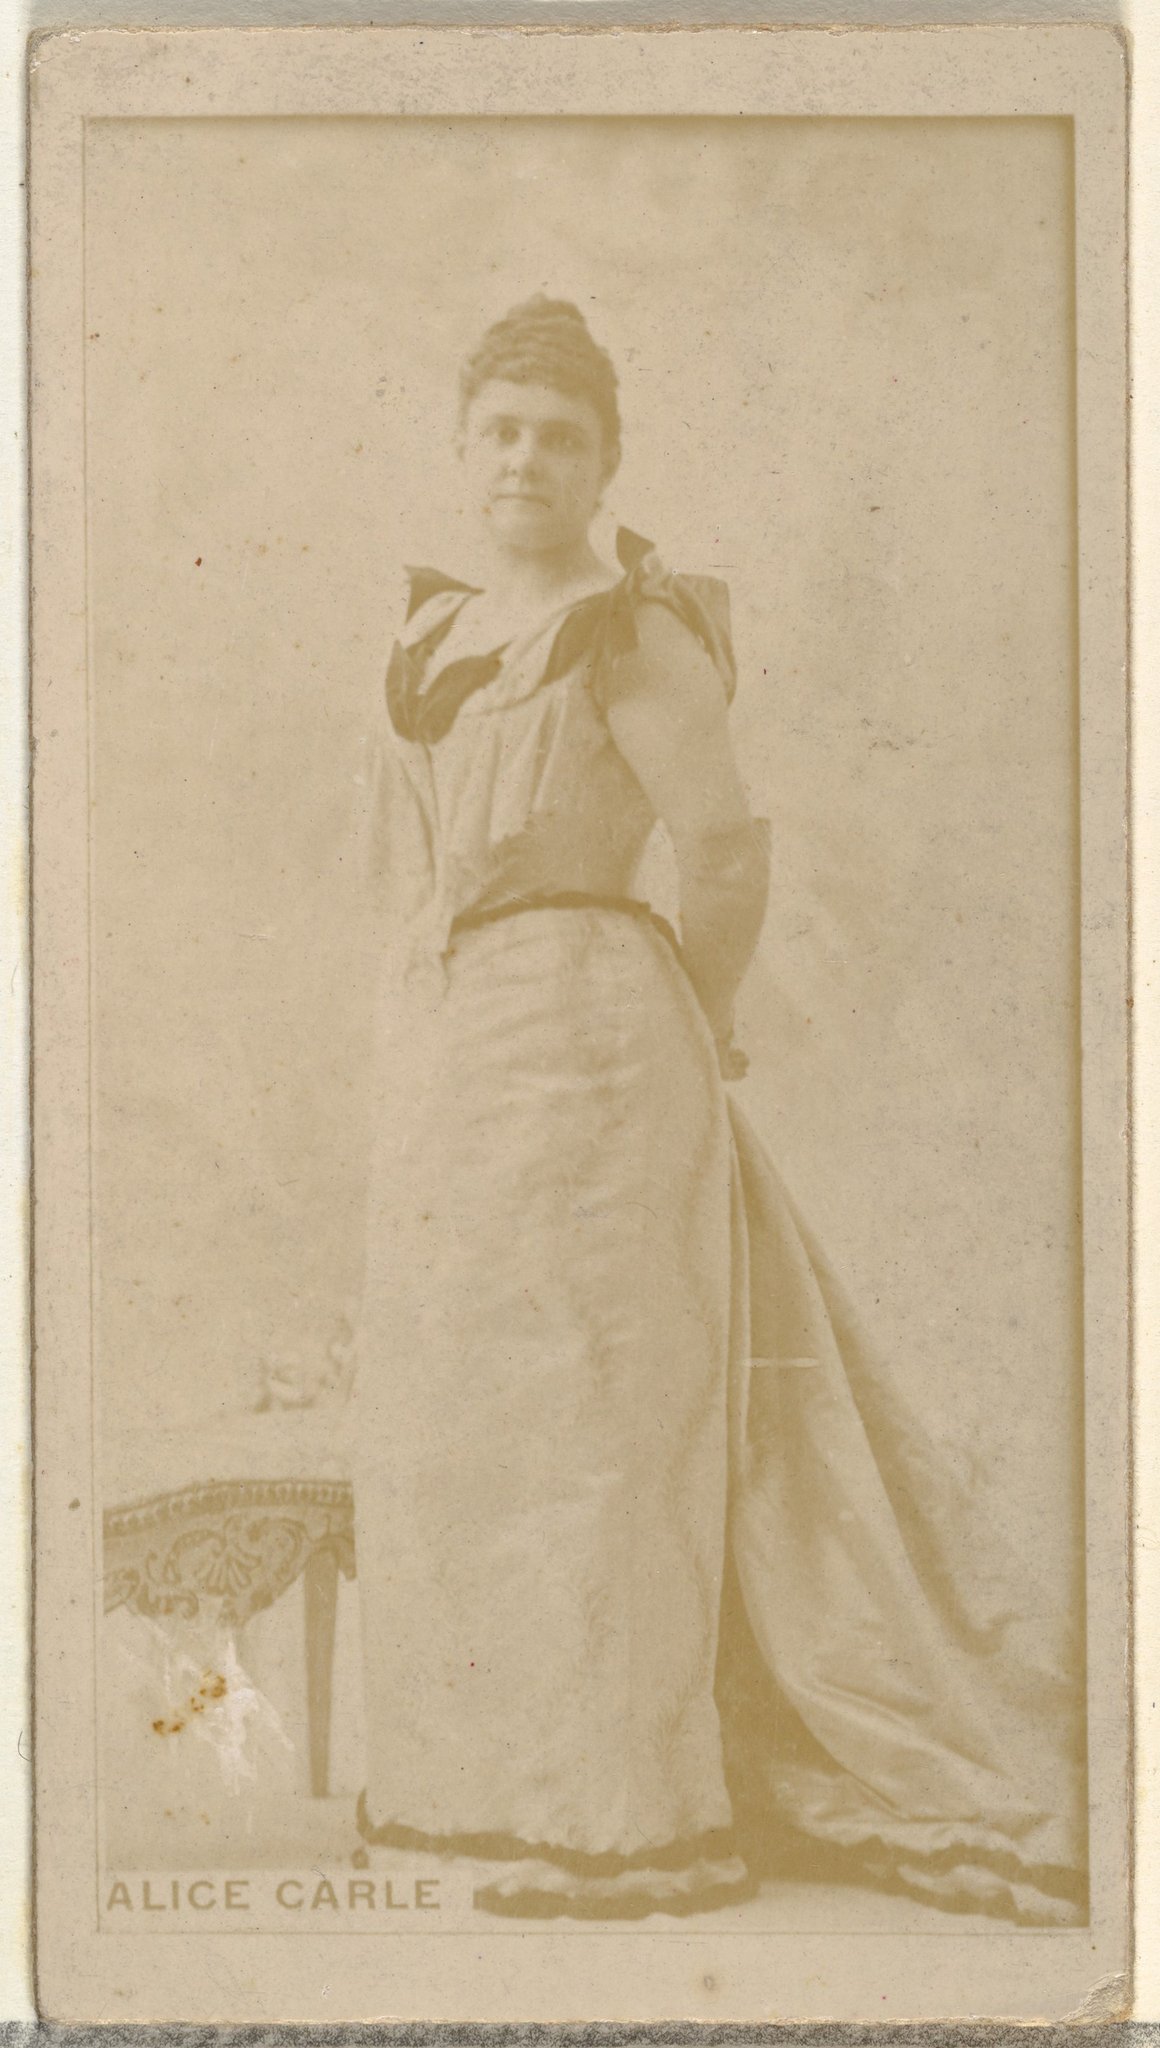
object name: photograph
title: Alice Carle, from the Actors and Actresses series (N145-8) issued by Duke Sons & Co. to promote Duke Cigarettes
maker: w. duke, sons & co.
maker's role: publisher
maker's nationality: american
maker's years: 1870-1920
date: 1891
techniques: albumen silver print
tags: portraits,women,actresses